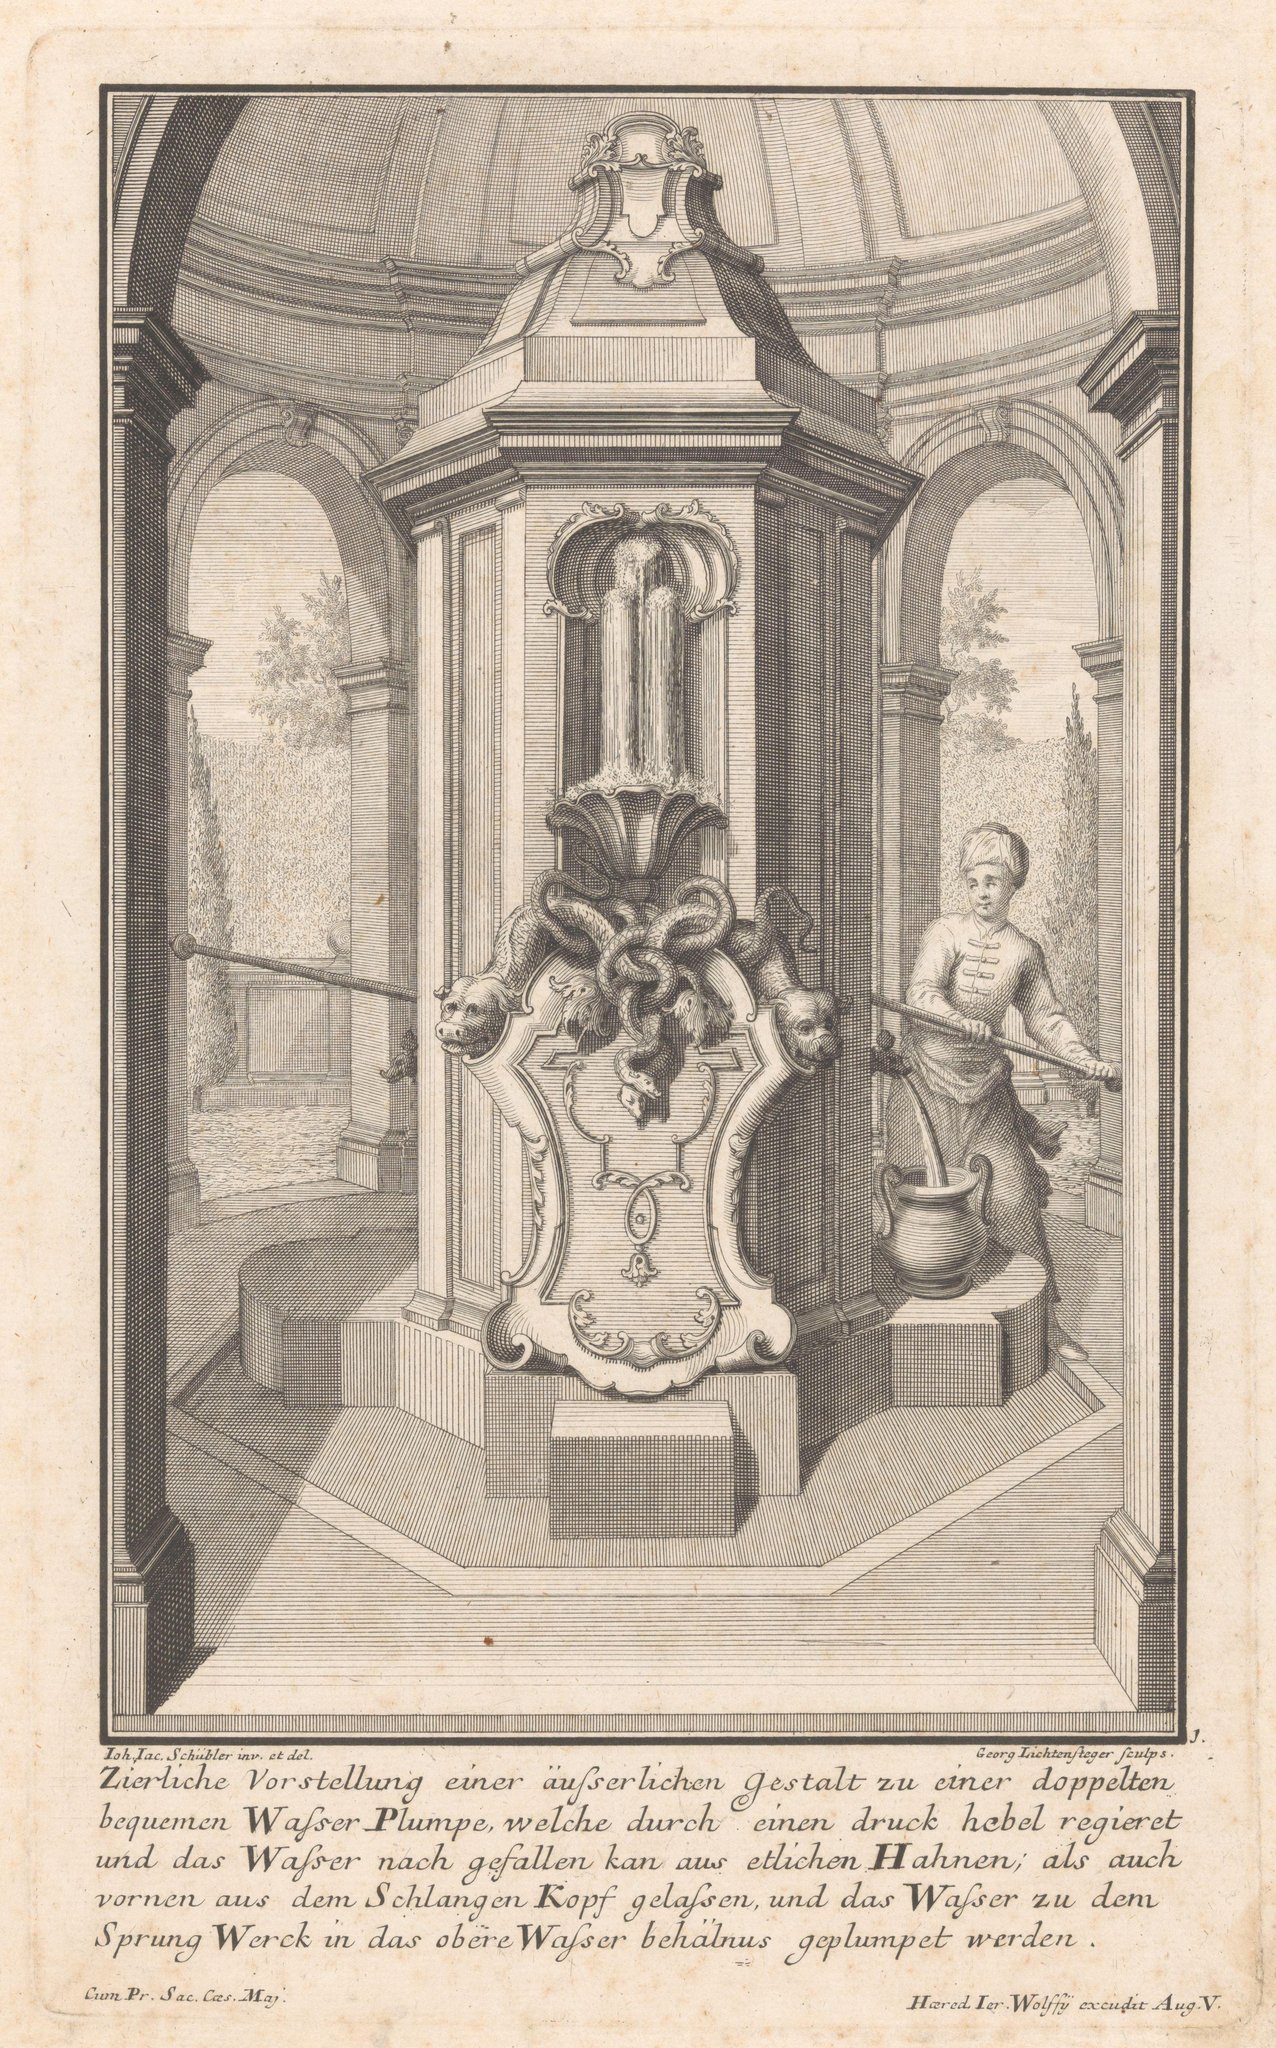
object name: print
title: Waterpomp met slangen en varkenskoppen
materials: paper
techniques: engraving, etching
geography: augsburg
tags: snakes, pig, utilitarian, public pump or water fountain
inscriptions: collector's mark: Lugt 2760, collector's mark: Lugt 2228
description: In een koepelgebouw staat een dubbele waterpomp gedecoreerd met rocaille ornamenten, slangen en varkenskoppen. Rechts pompt een man water. In de ondermarge een vijfregelige Duitse tekst.